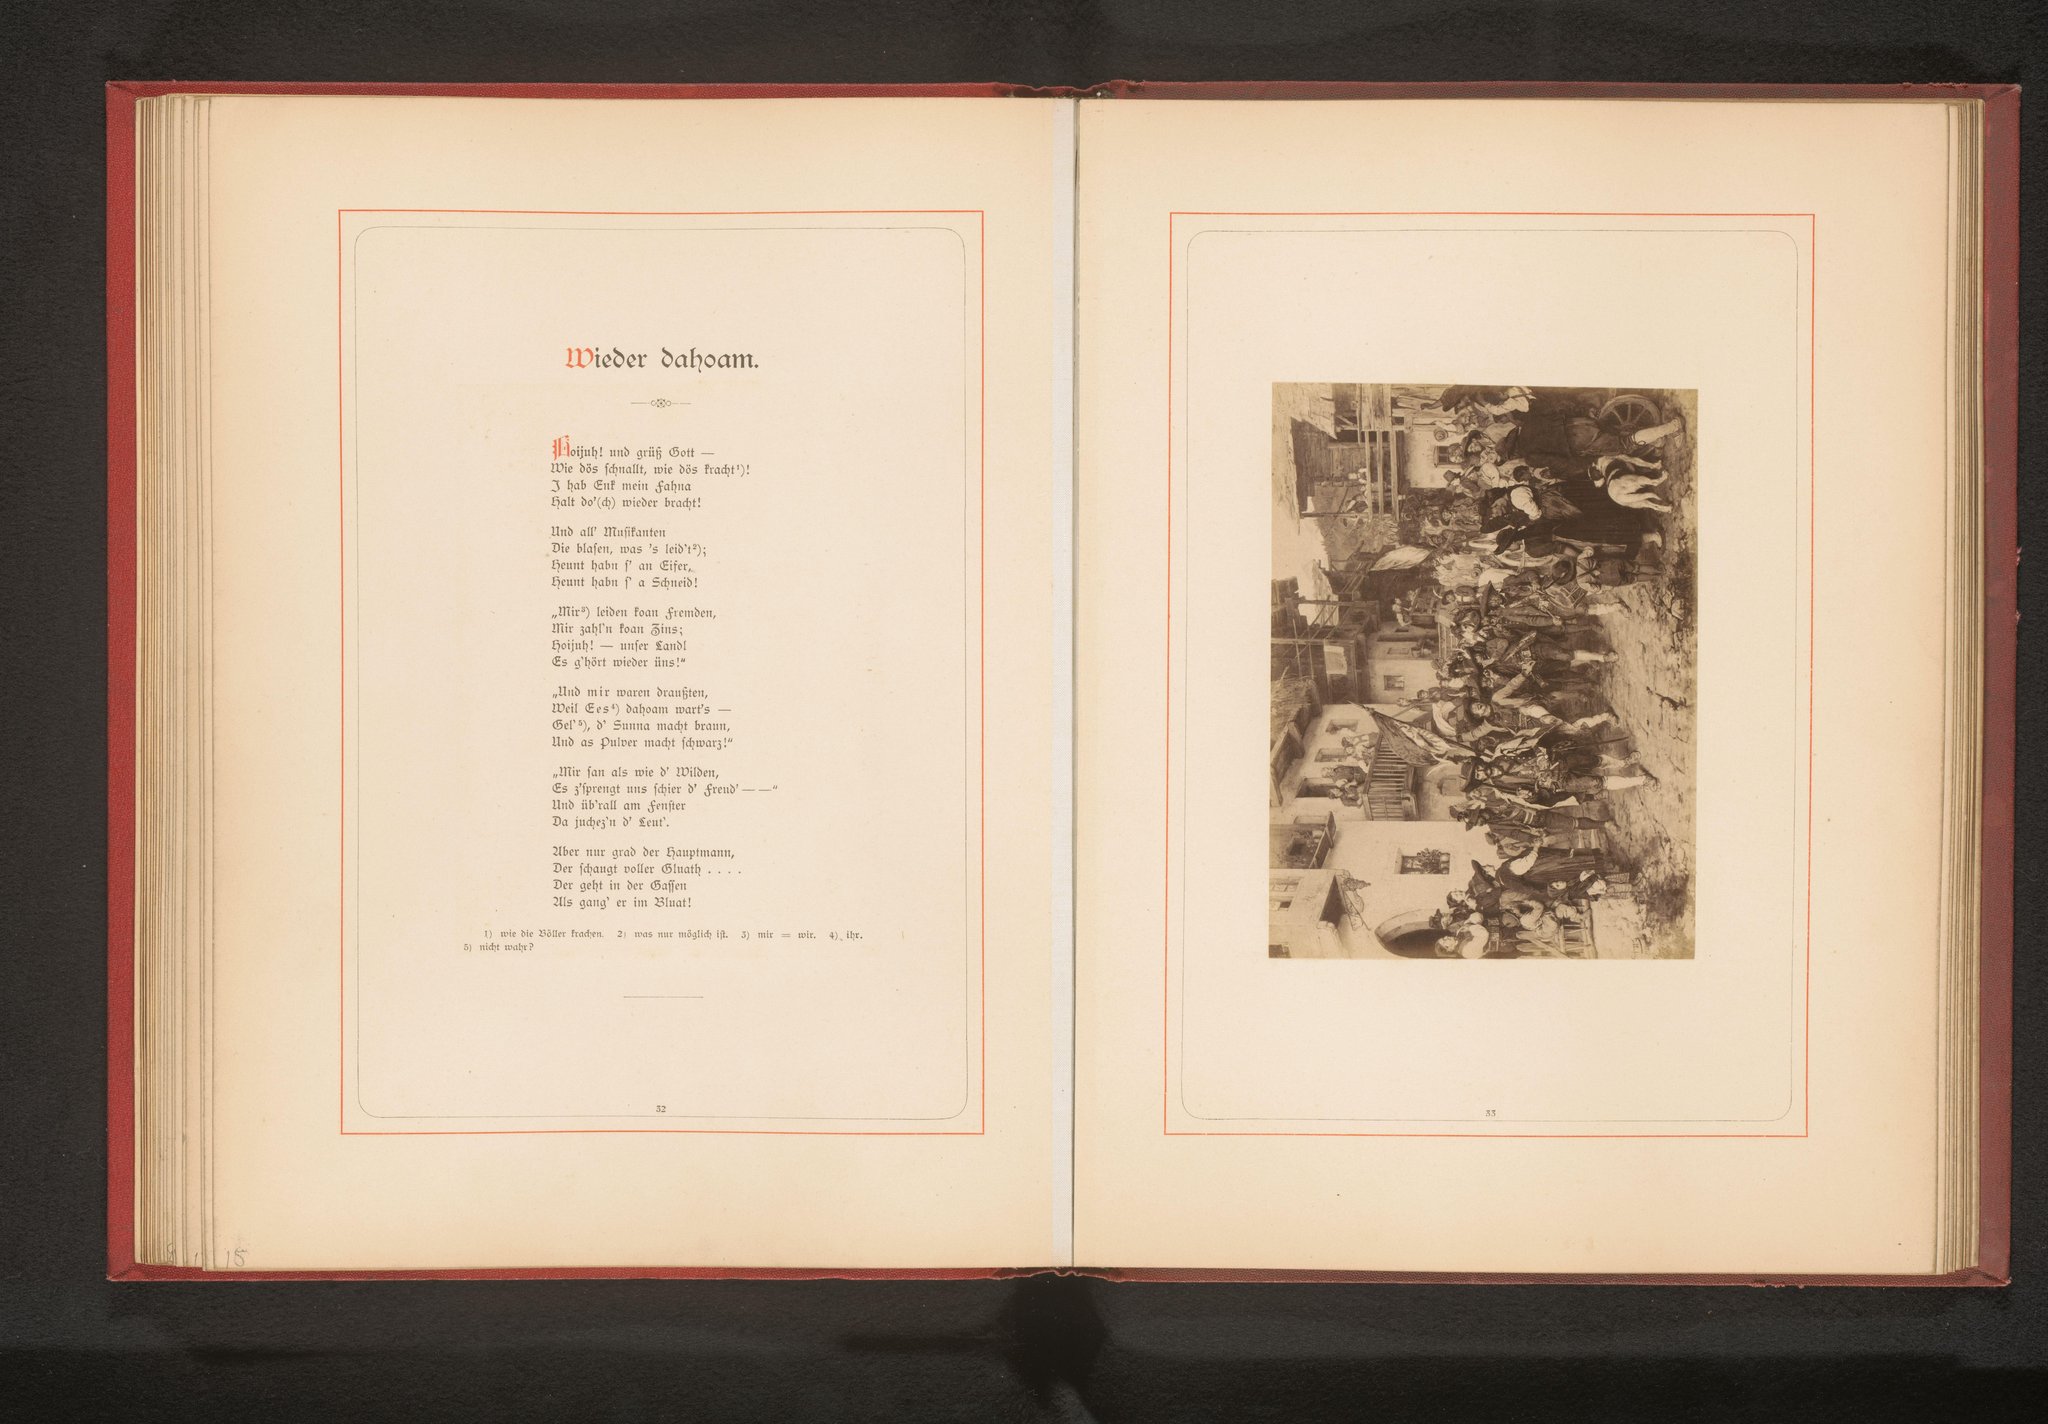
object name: photograph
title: Fotoreproductie van een schilderij, voorstellende de terugkeer van een leger in een stad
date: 1876-1885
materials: photographic support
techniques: albumen print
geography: germany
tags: return of the soldiers to civilian life, returning home